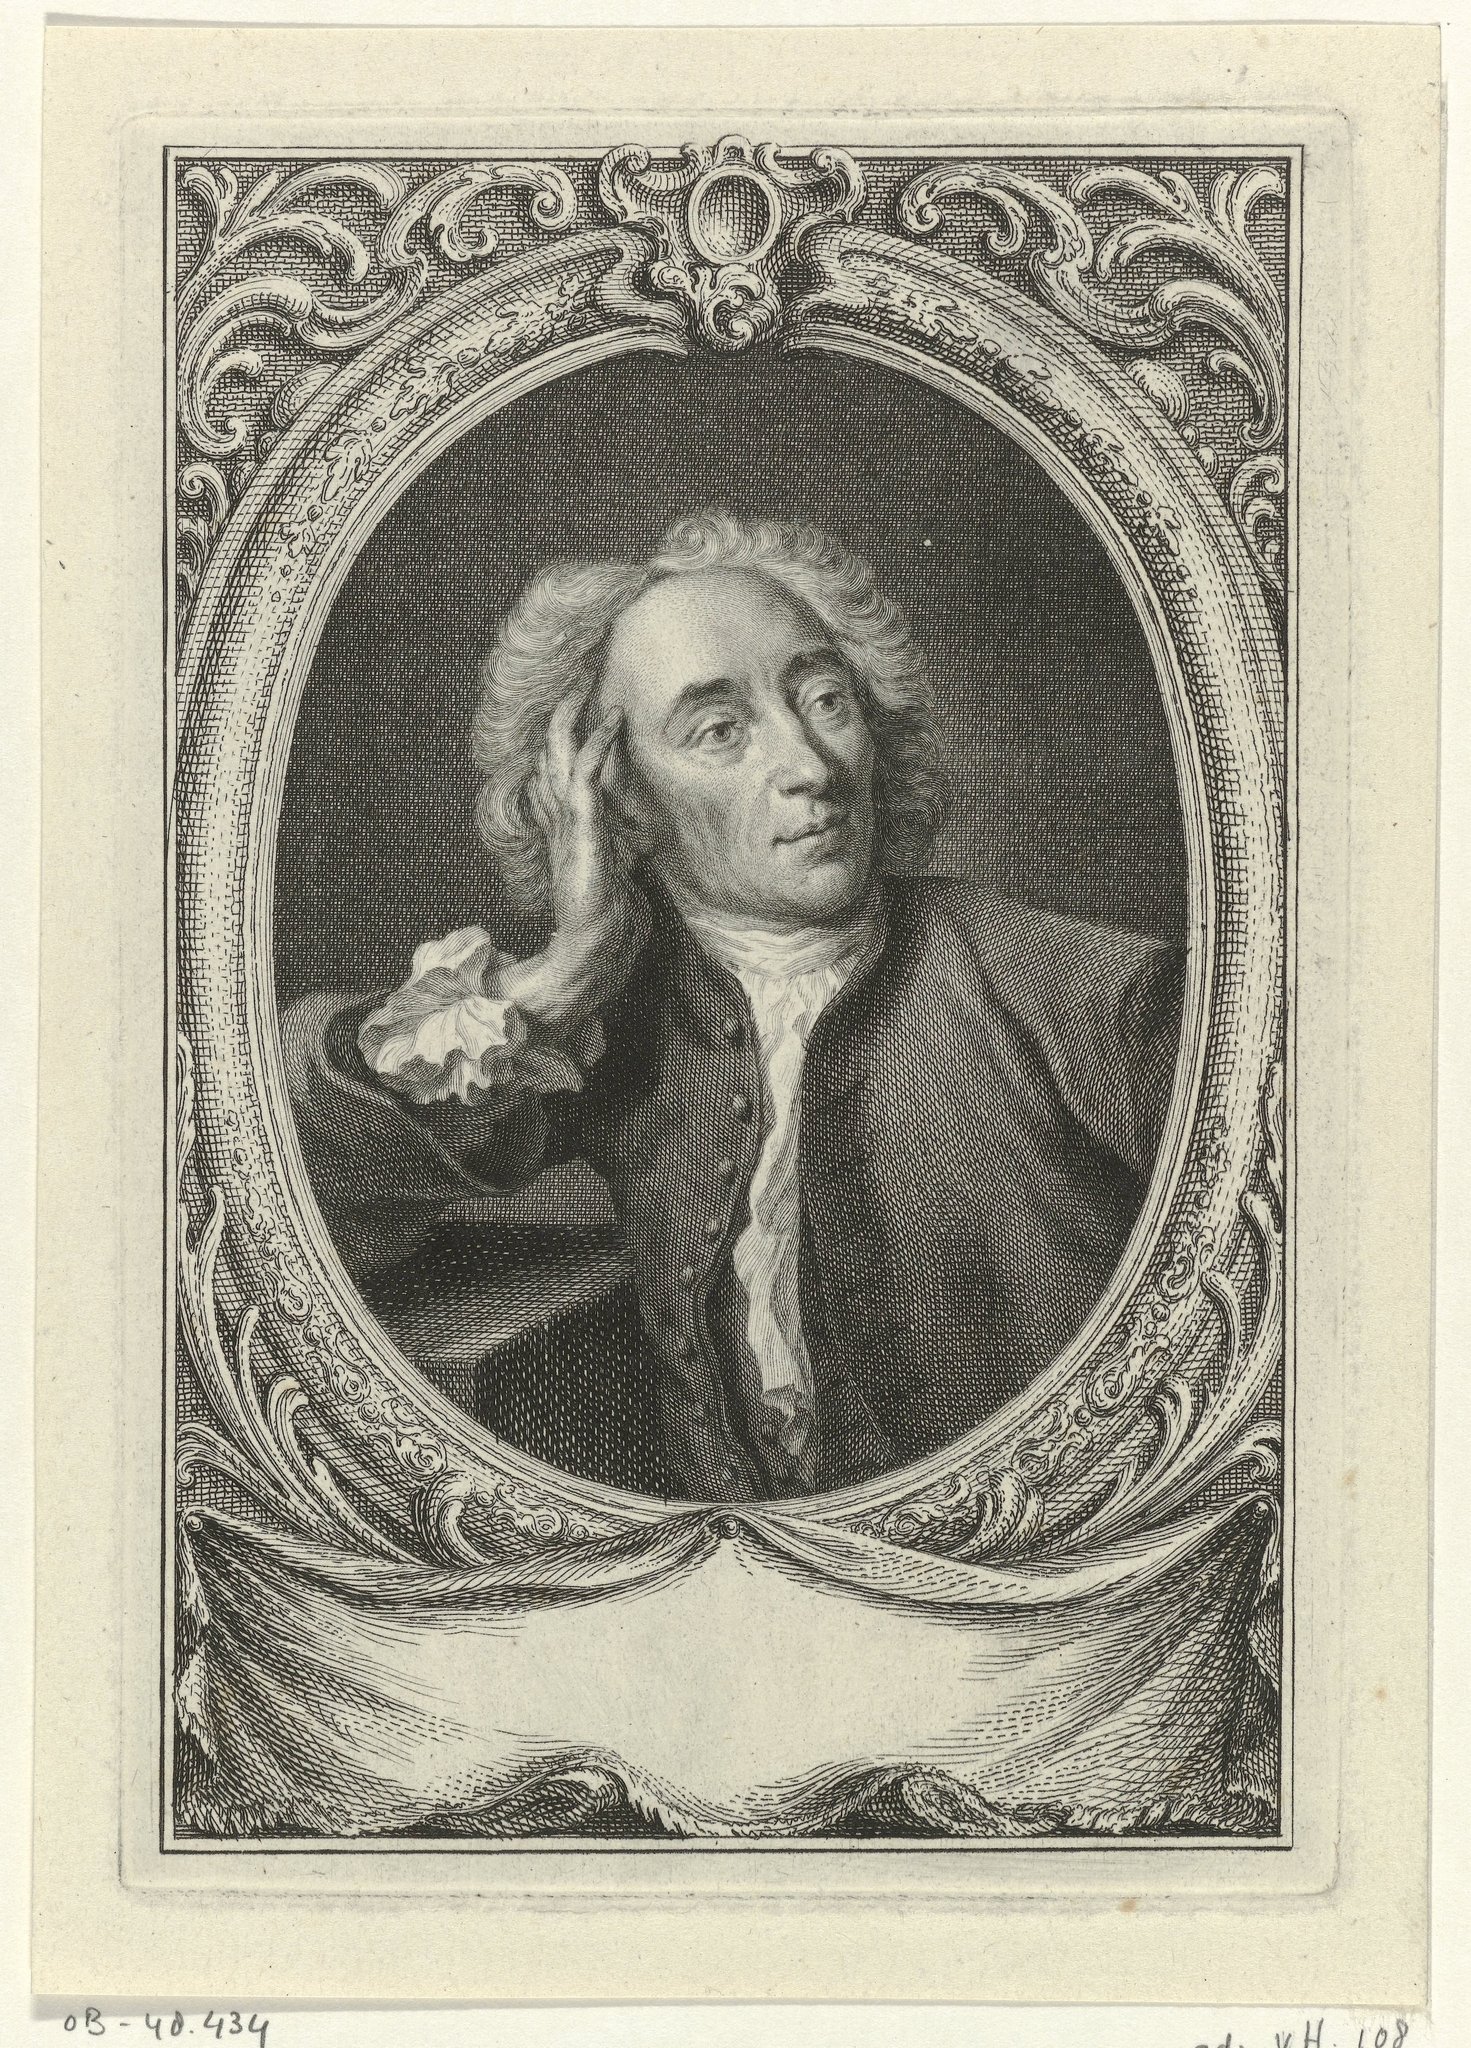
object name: print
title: Portret van Alexander Pope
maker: jacob houbraken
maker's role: draughtsman, print maker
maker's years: 1698-1780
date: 1708-1780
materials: paper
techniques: engraving, etching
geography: amsterdam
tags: alexander pope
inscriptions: collector's mark: Lugt 240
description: Alexander Pope, ten halven lijve in een ovaal ornamenteel medaillon. Met zijn linkerelleboog steunt hij op een tafel naast hem. Onder het portret een uitgespreide doek aan drie ophangpunten.